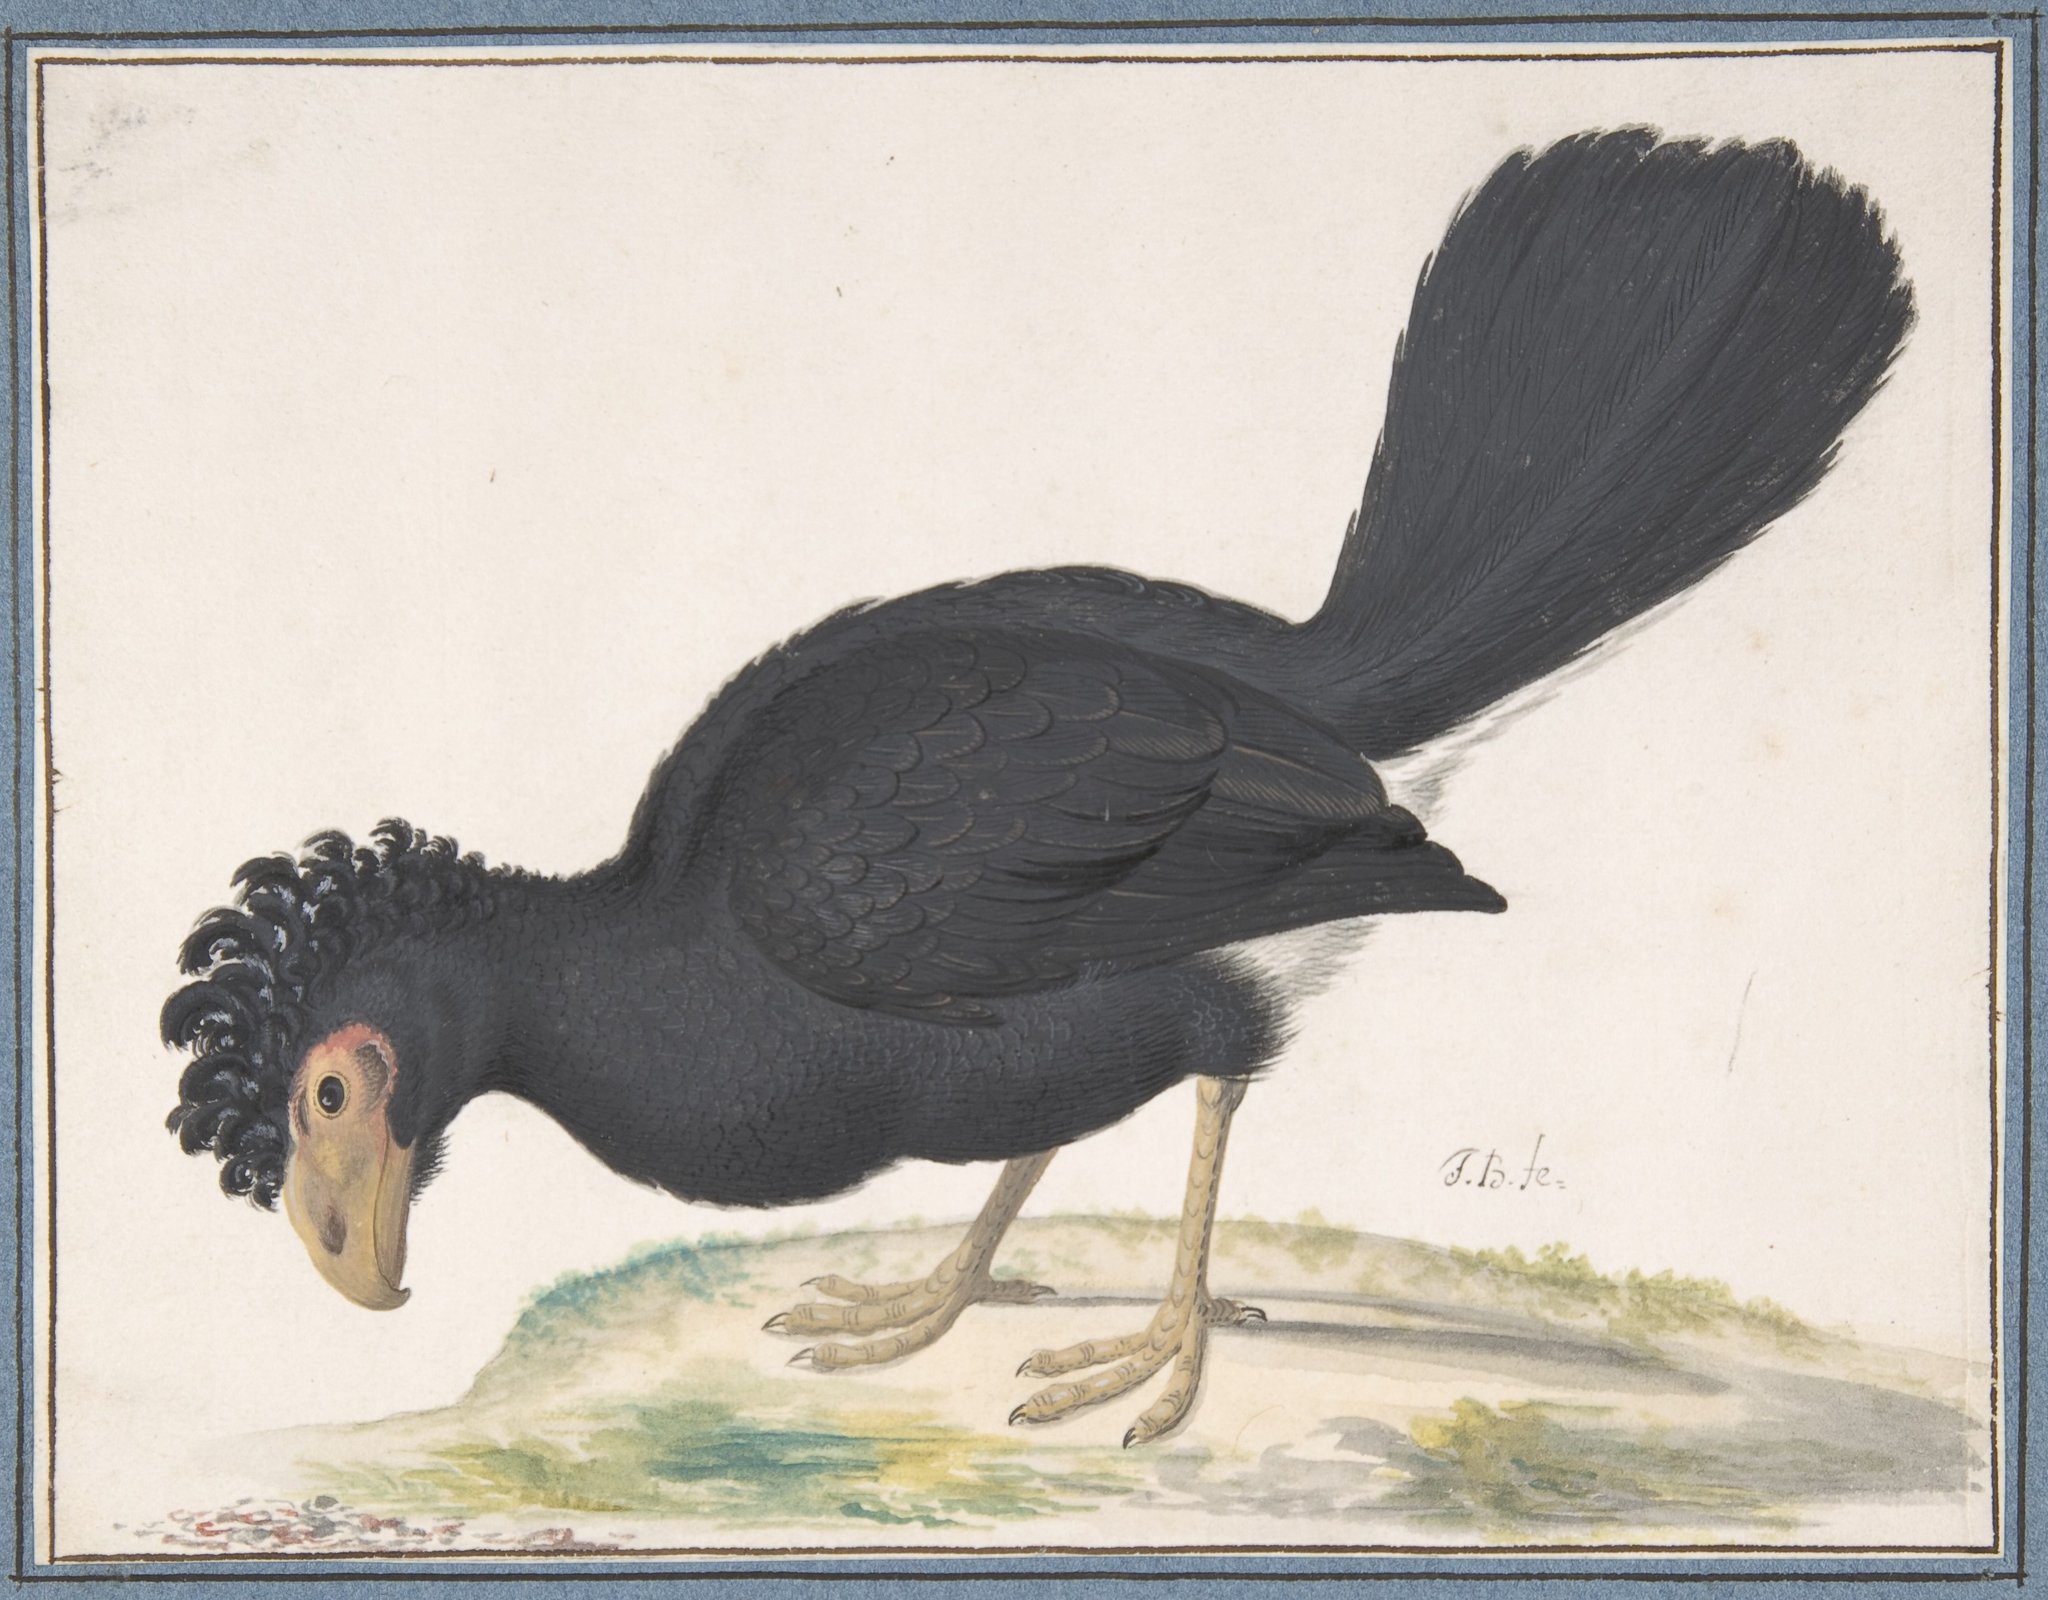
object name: drawing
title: A Black Curassow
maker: johannes bronckhorst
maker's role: artist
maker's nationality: dutch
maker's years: 1648-1727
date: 1667-1733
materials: chalk, gouache, watercolor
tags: birds